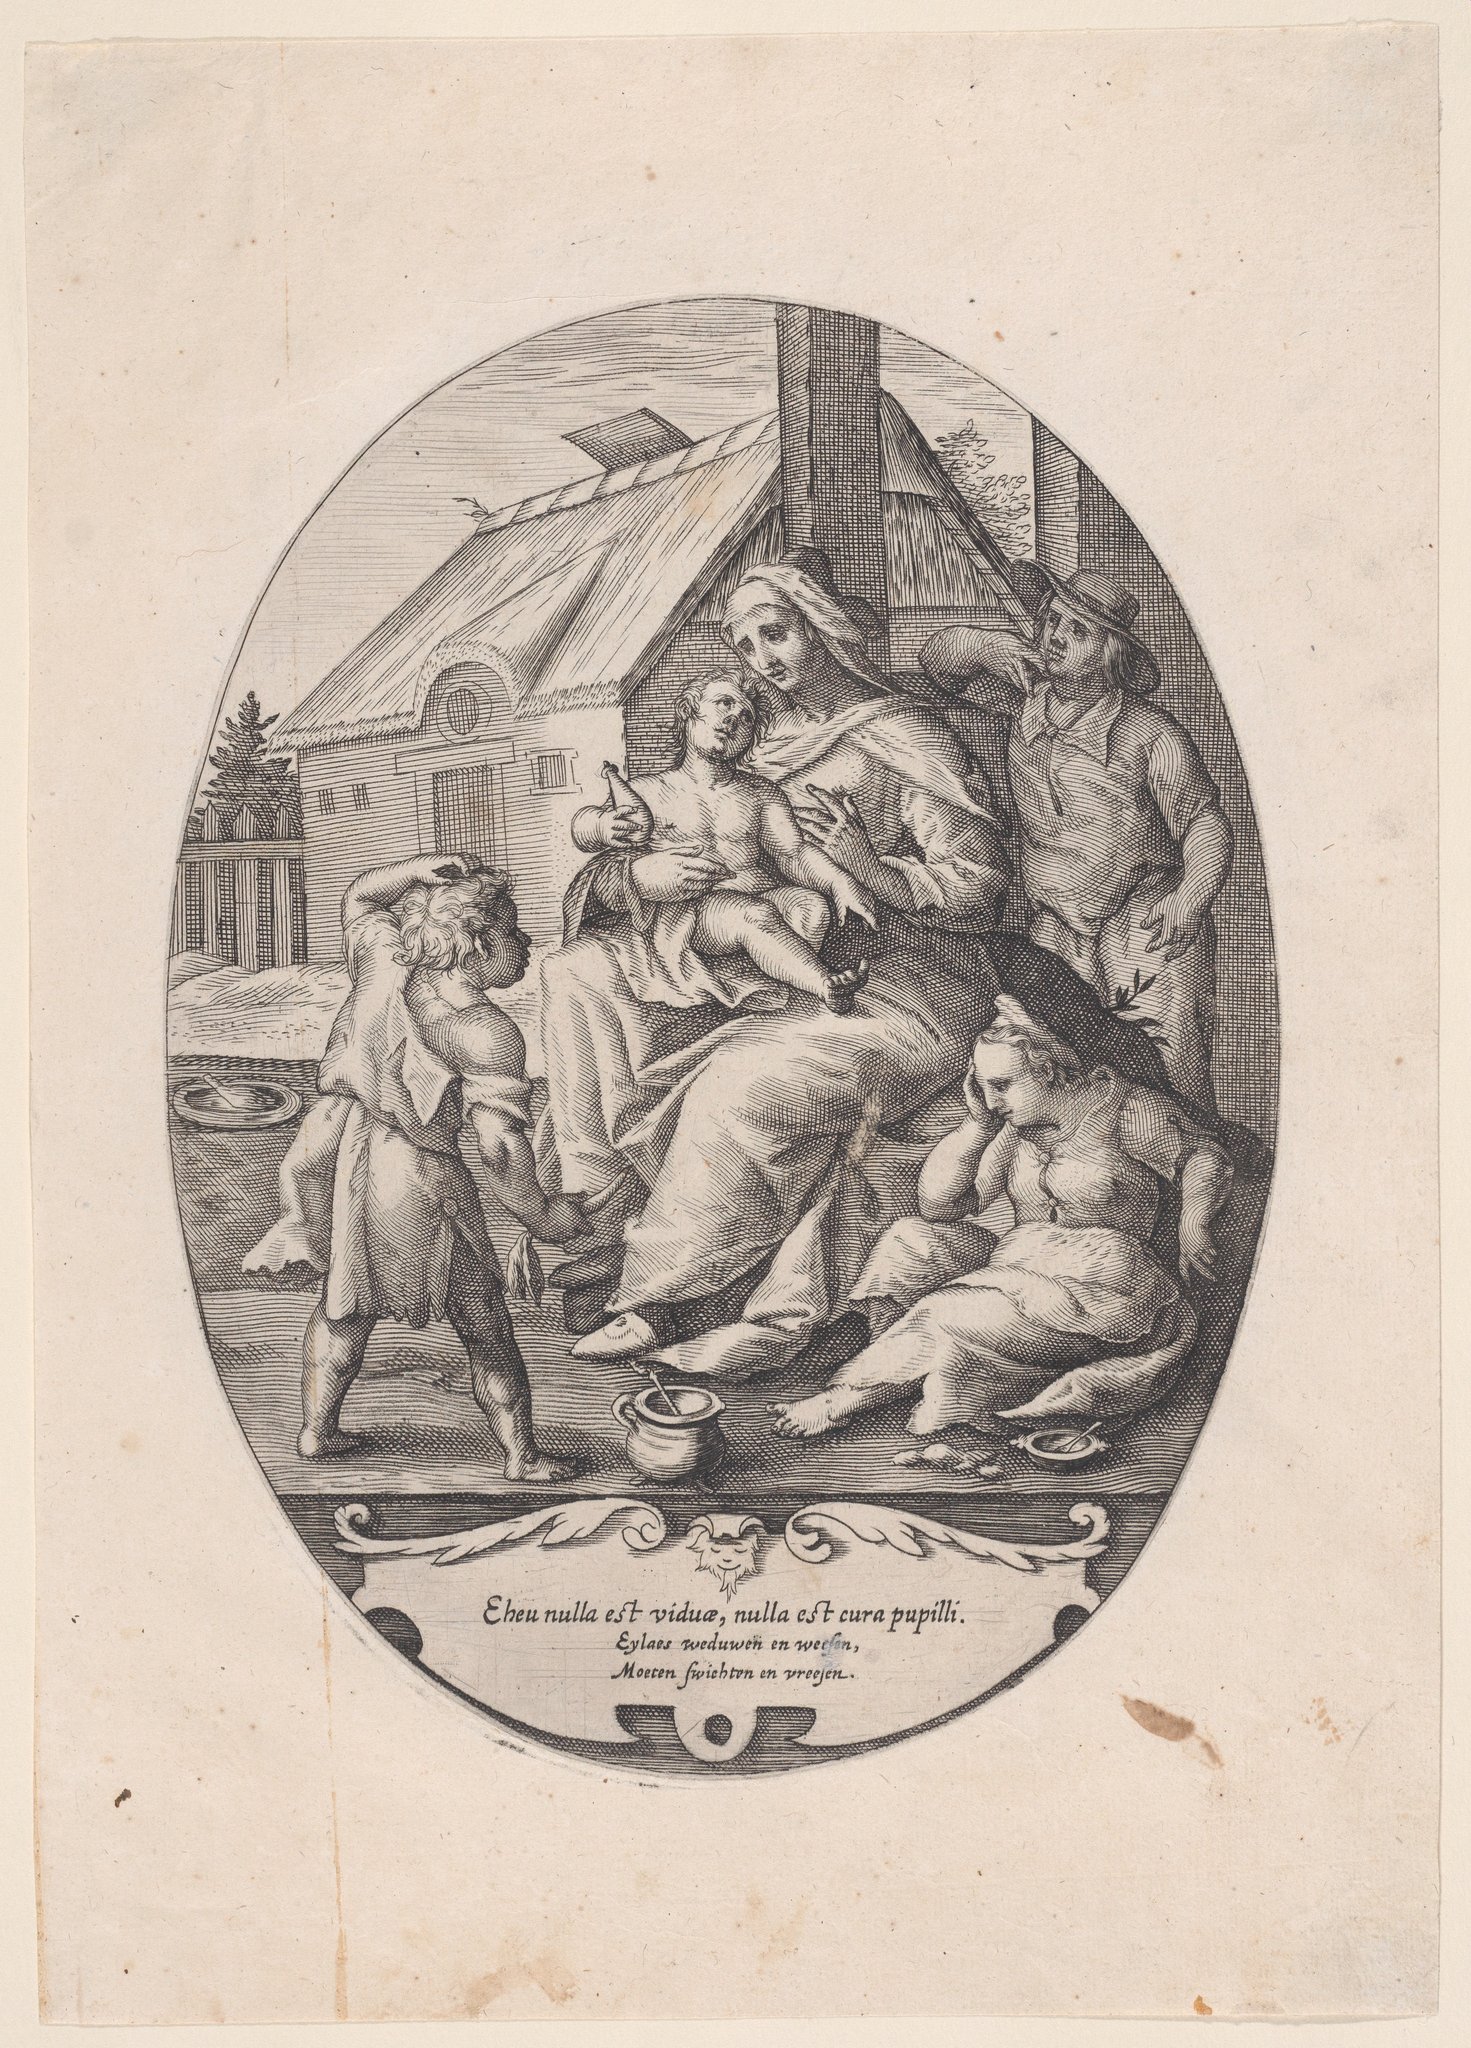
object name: print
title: Allegory on Widowhood and Orphanage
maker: lambert cornelisz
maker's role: artist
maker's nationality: dutch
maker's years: 1593-1621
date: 1590-1630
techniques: engraving